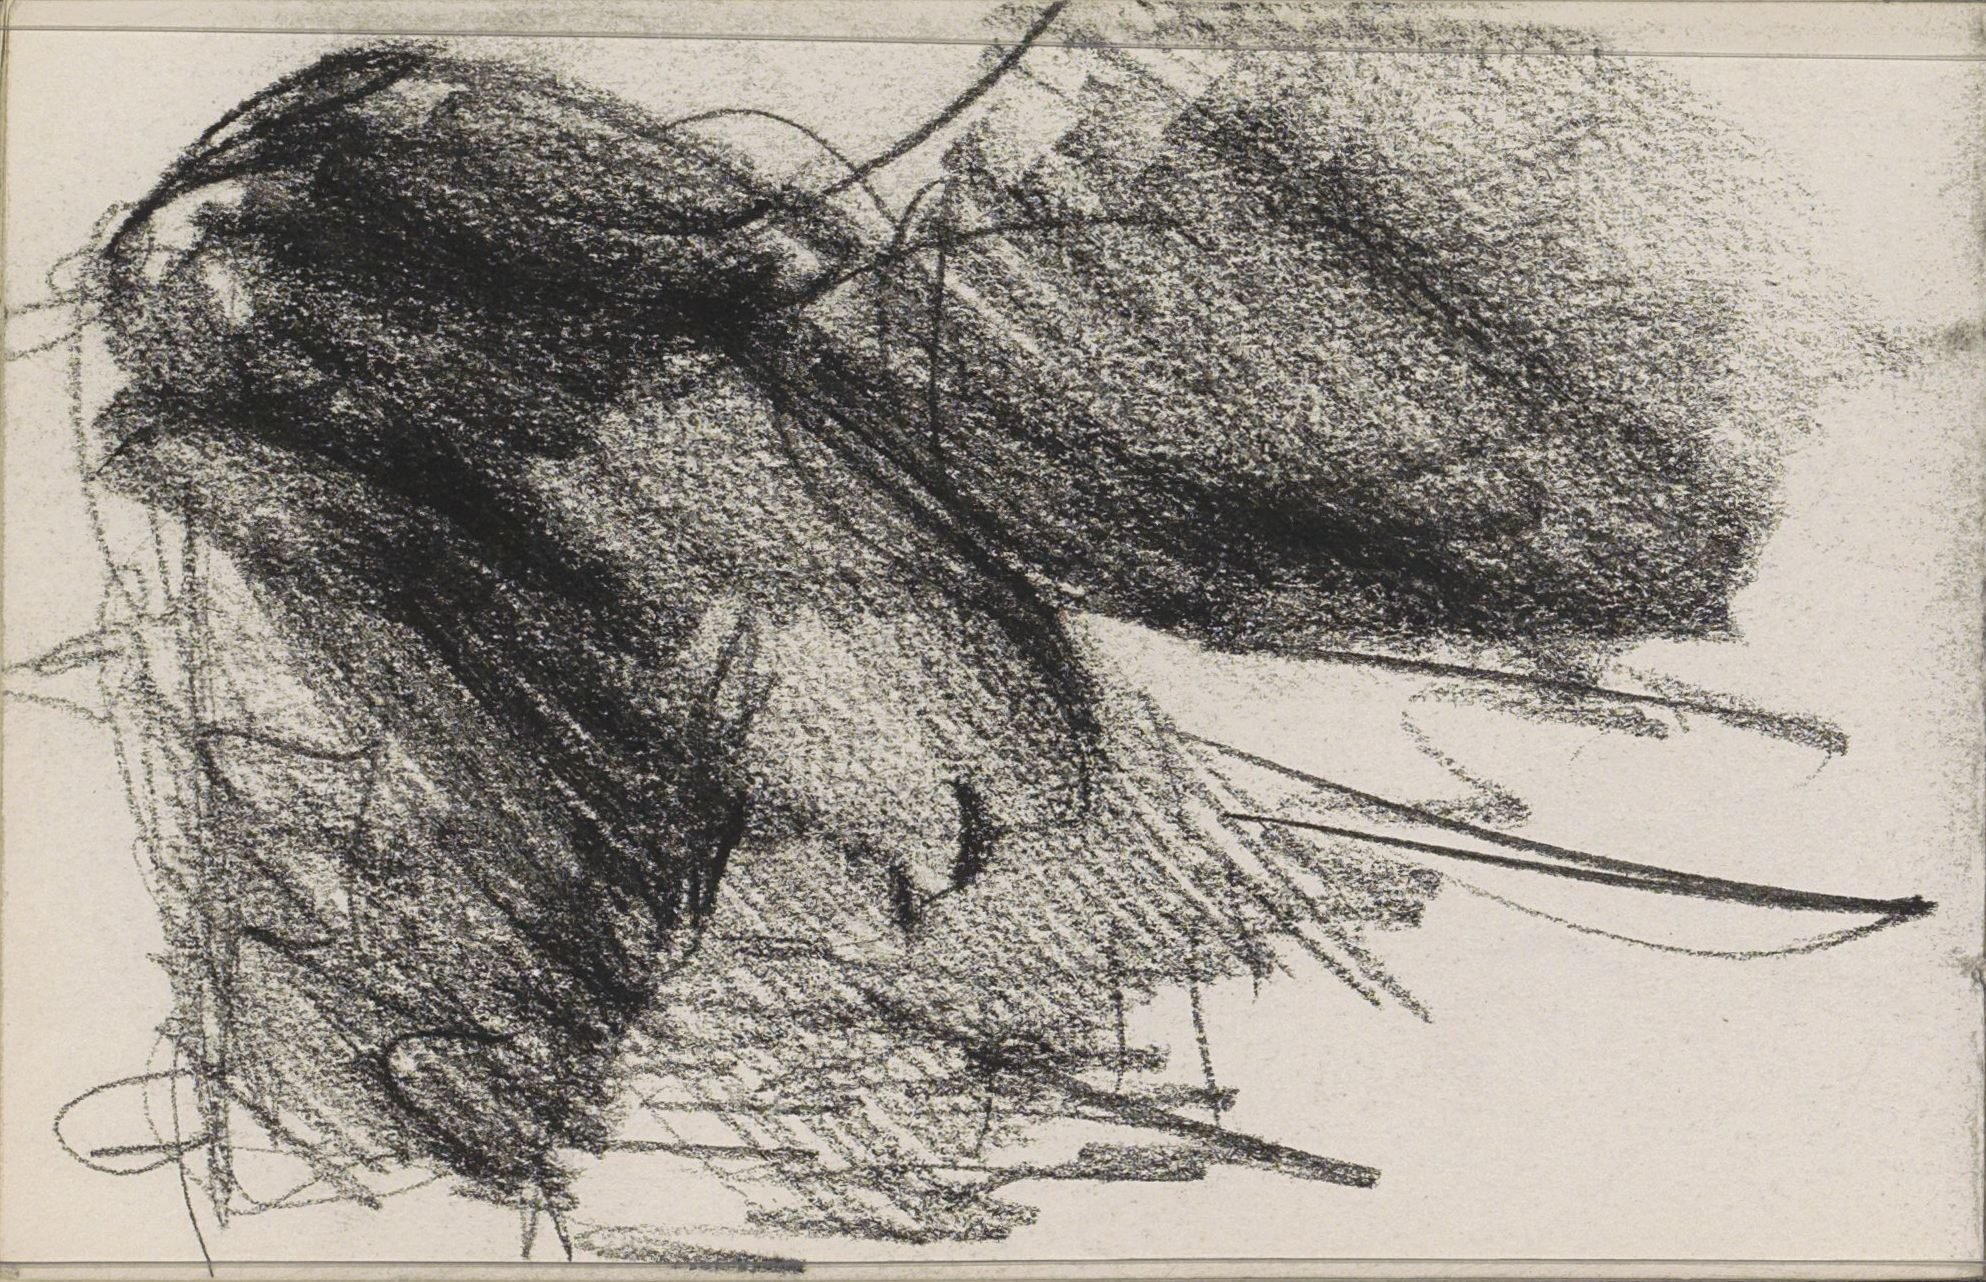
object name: sketchbook leaf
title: Vrouw met hoed, in profiel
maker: isaac israels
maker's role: draughtsman, painter, print maker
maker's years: 1865-1934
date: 1887-1934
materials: chalk, paper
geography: paris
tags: head-gear: hat (+ women's clothes), adult woman (+ sideview, profile), street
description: Op de achtergrond mogelijk een straat. Pagina 23 uit schetsboek XLIX met 32 pagina's.